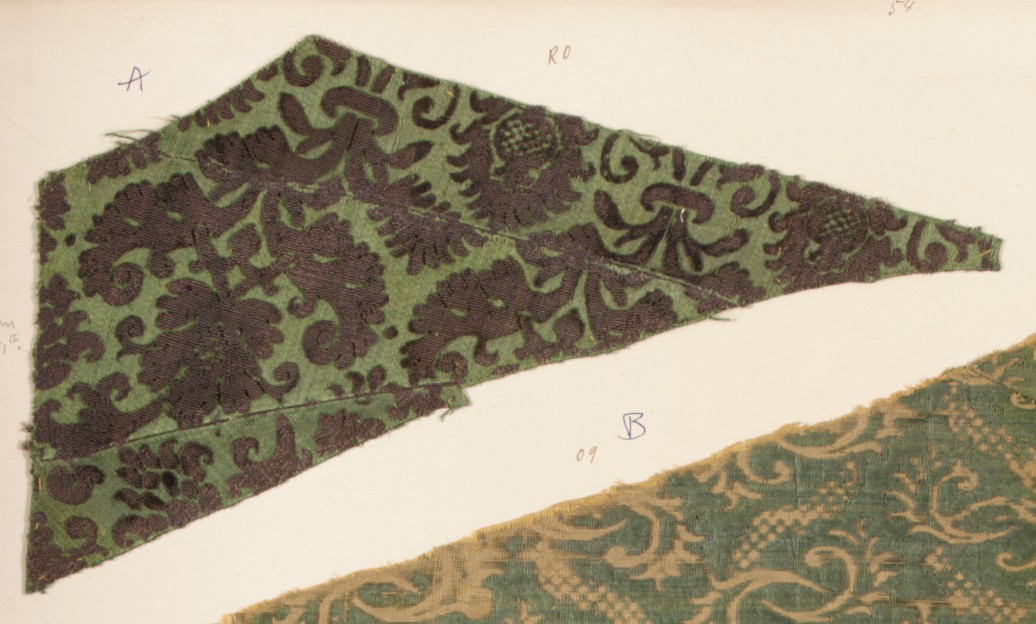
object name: fragment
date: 1567-1600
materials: silk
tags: leaves